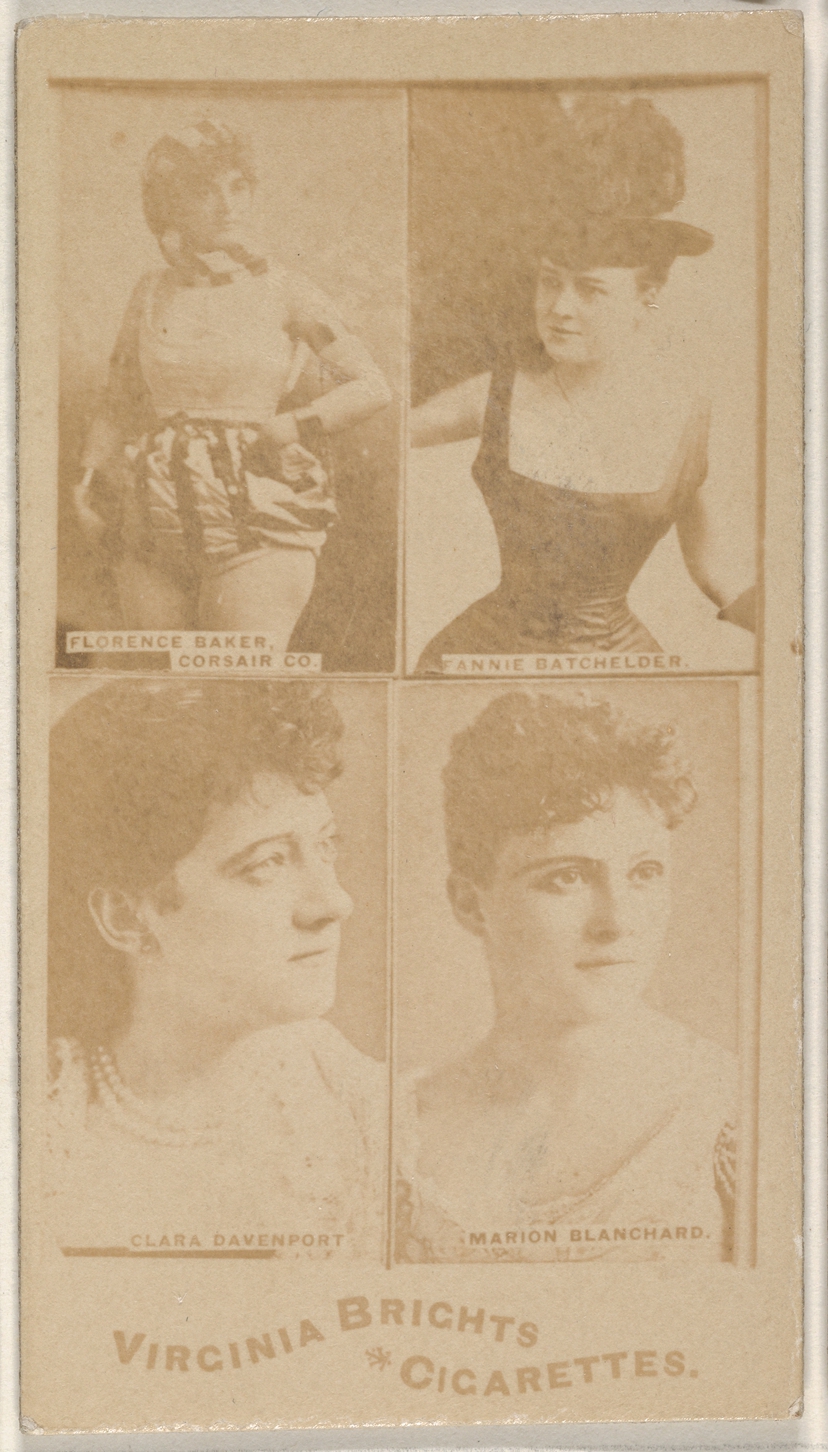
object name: photograph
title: Florence Baker, Corsair Co./ Fannie Batchelder/ Clara Davenport/ Marion Blanchard, from the Actors and Actresses series (N45, Type 4) for Virginia Brights Cigarettes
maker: allen & ginter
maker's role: publisher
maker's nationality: american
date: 1888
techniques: albumen silver print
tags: portraits,women,actresses